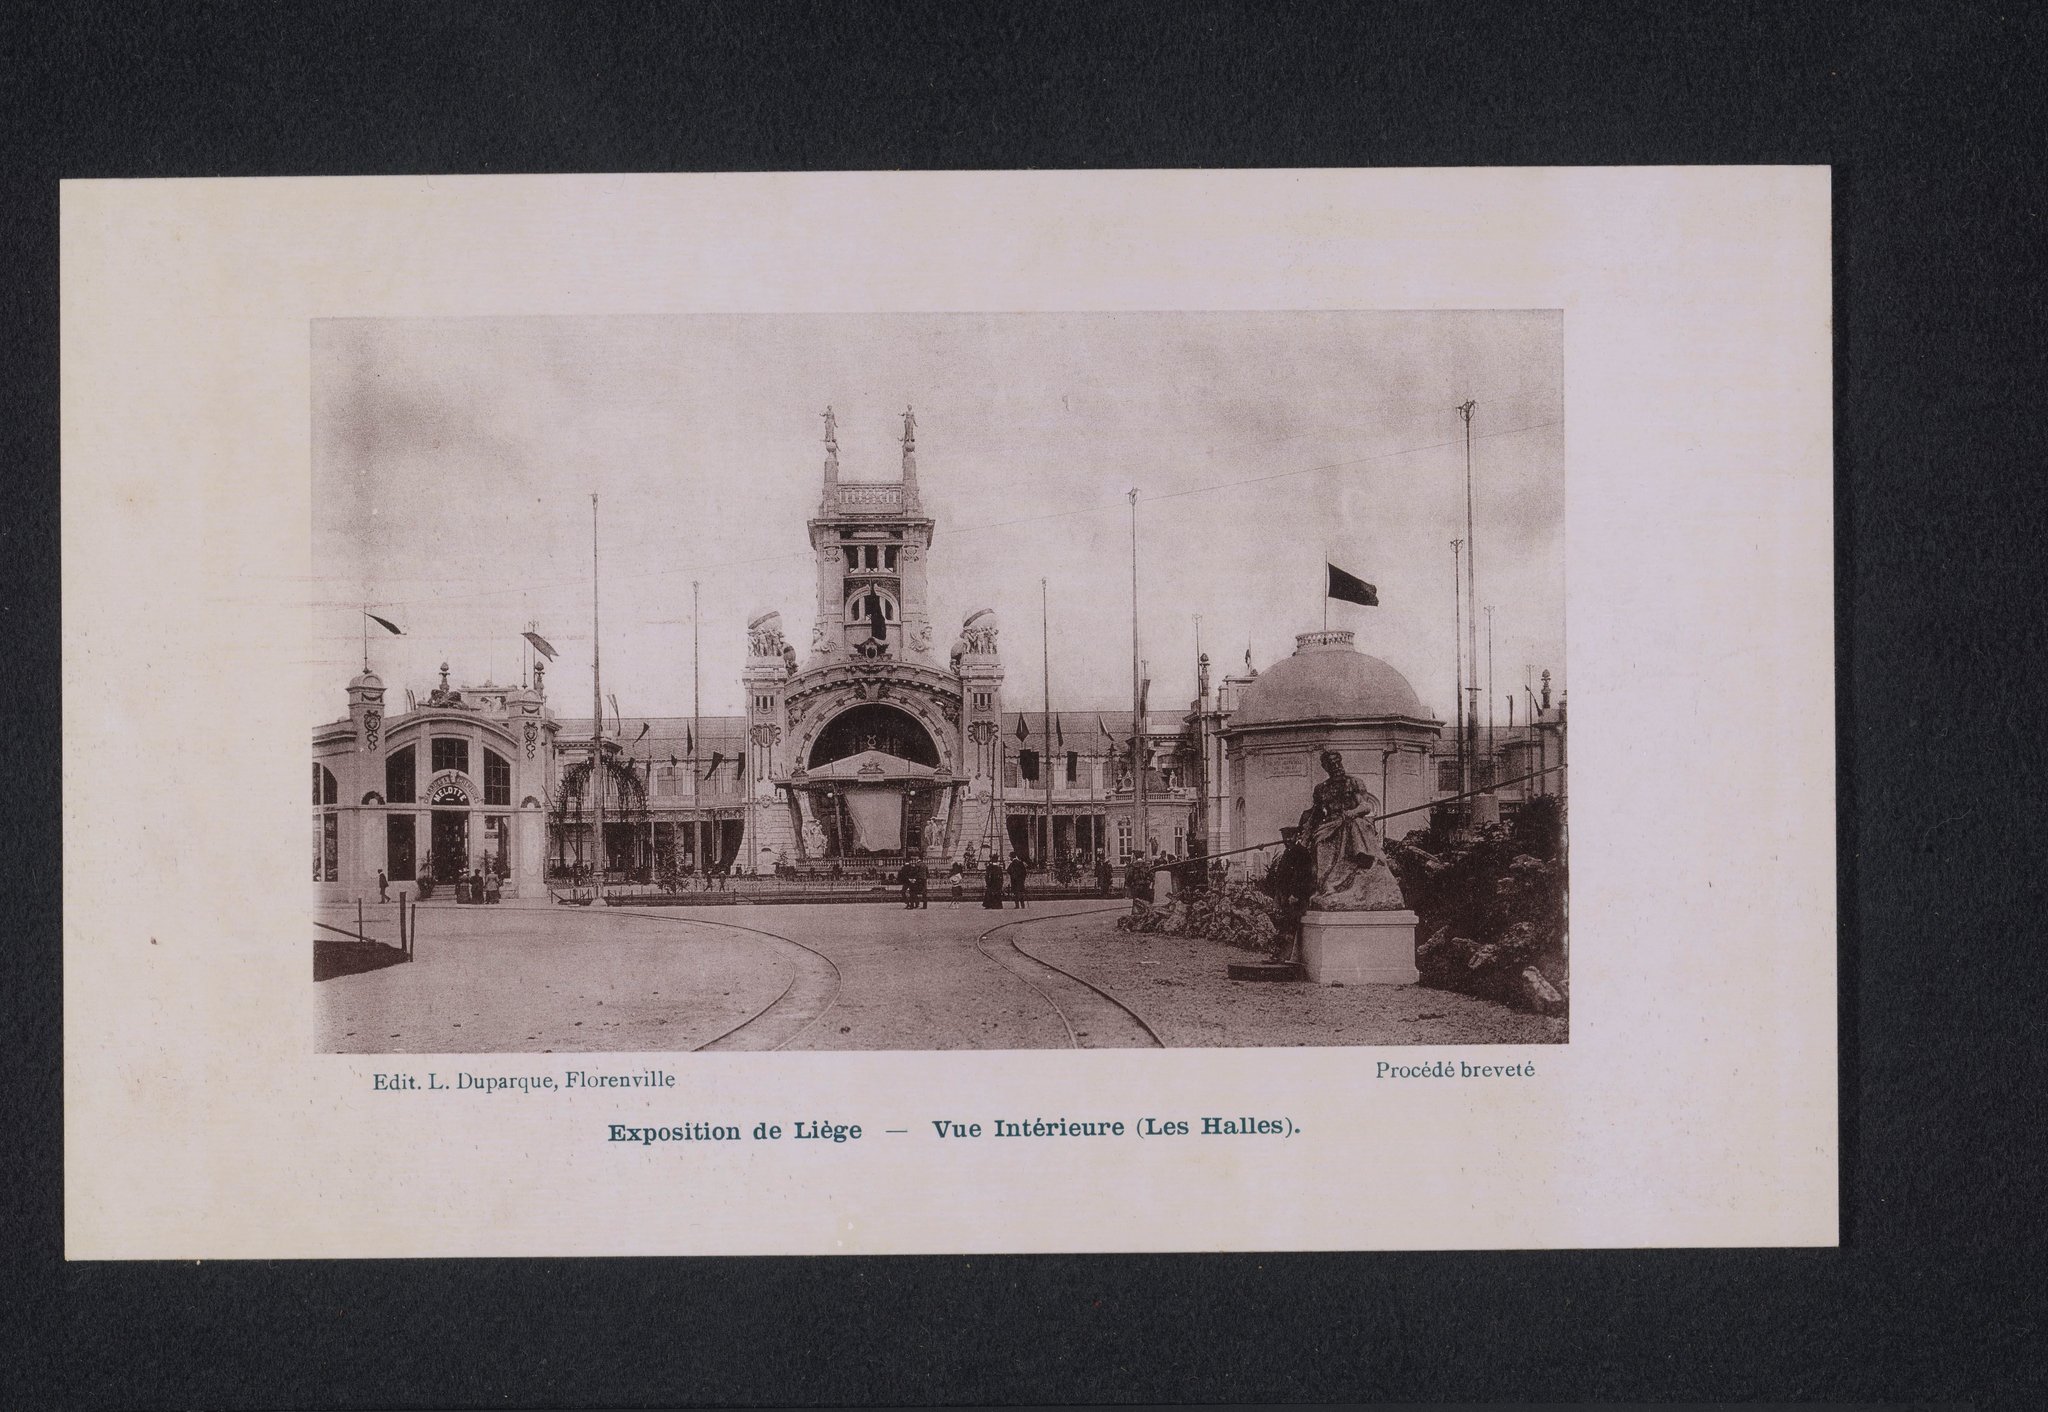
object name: photomechanical print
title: Vue Intérieure (Les Halles)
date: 1905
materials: paper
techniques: photograph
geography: florenville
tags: world fair, world exhibition, liège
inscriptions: inscription: ‘Procédé breveté’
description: Deze prent maakt deel uit van een omslag met 16 prenten.